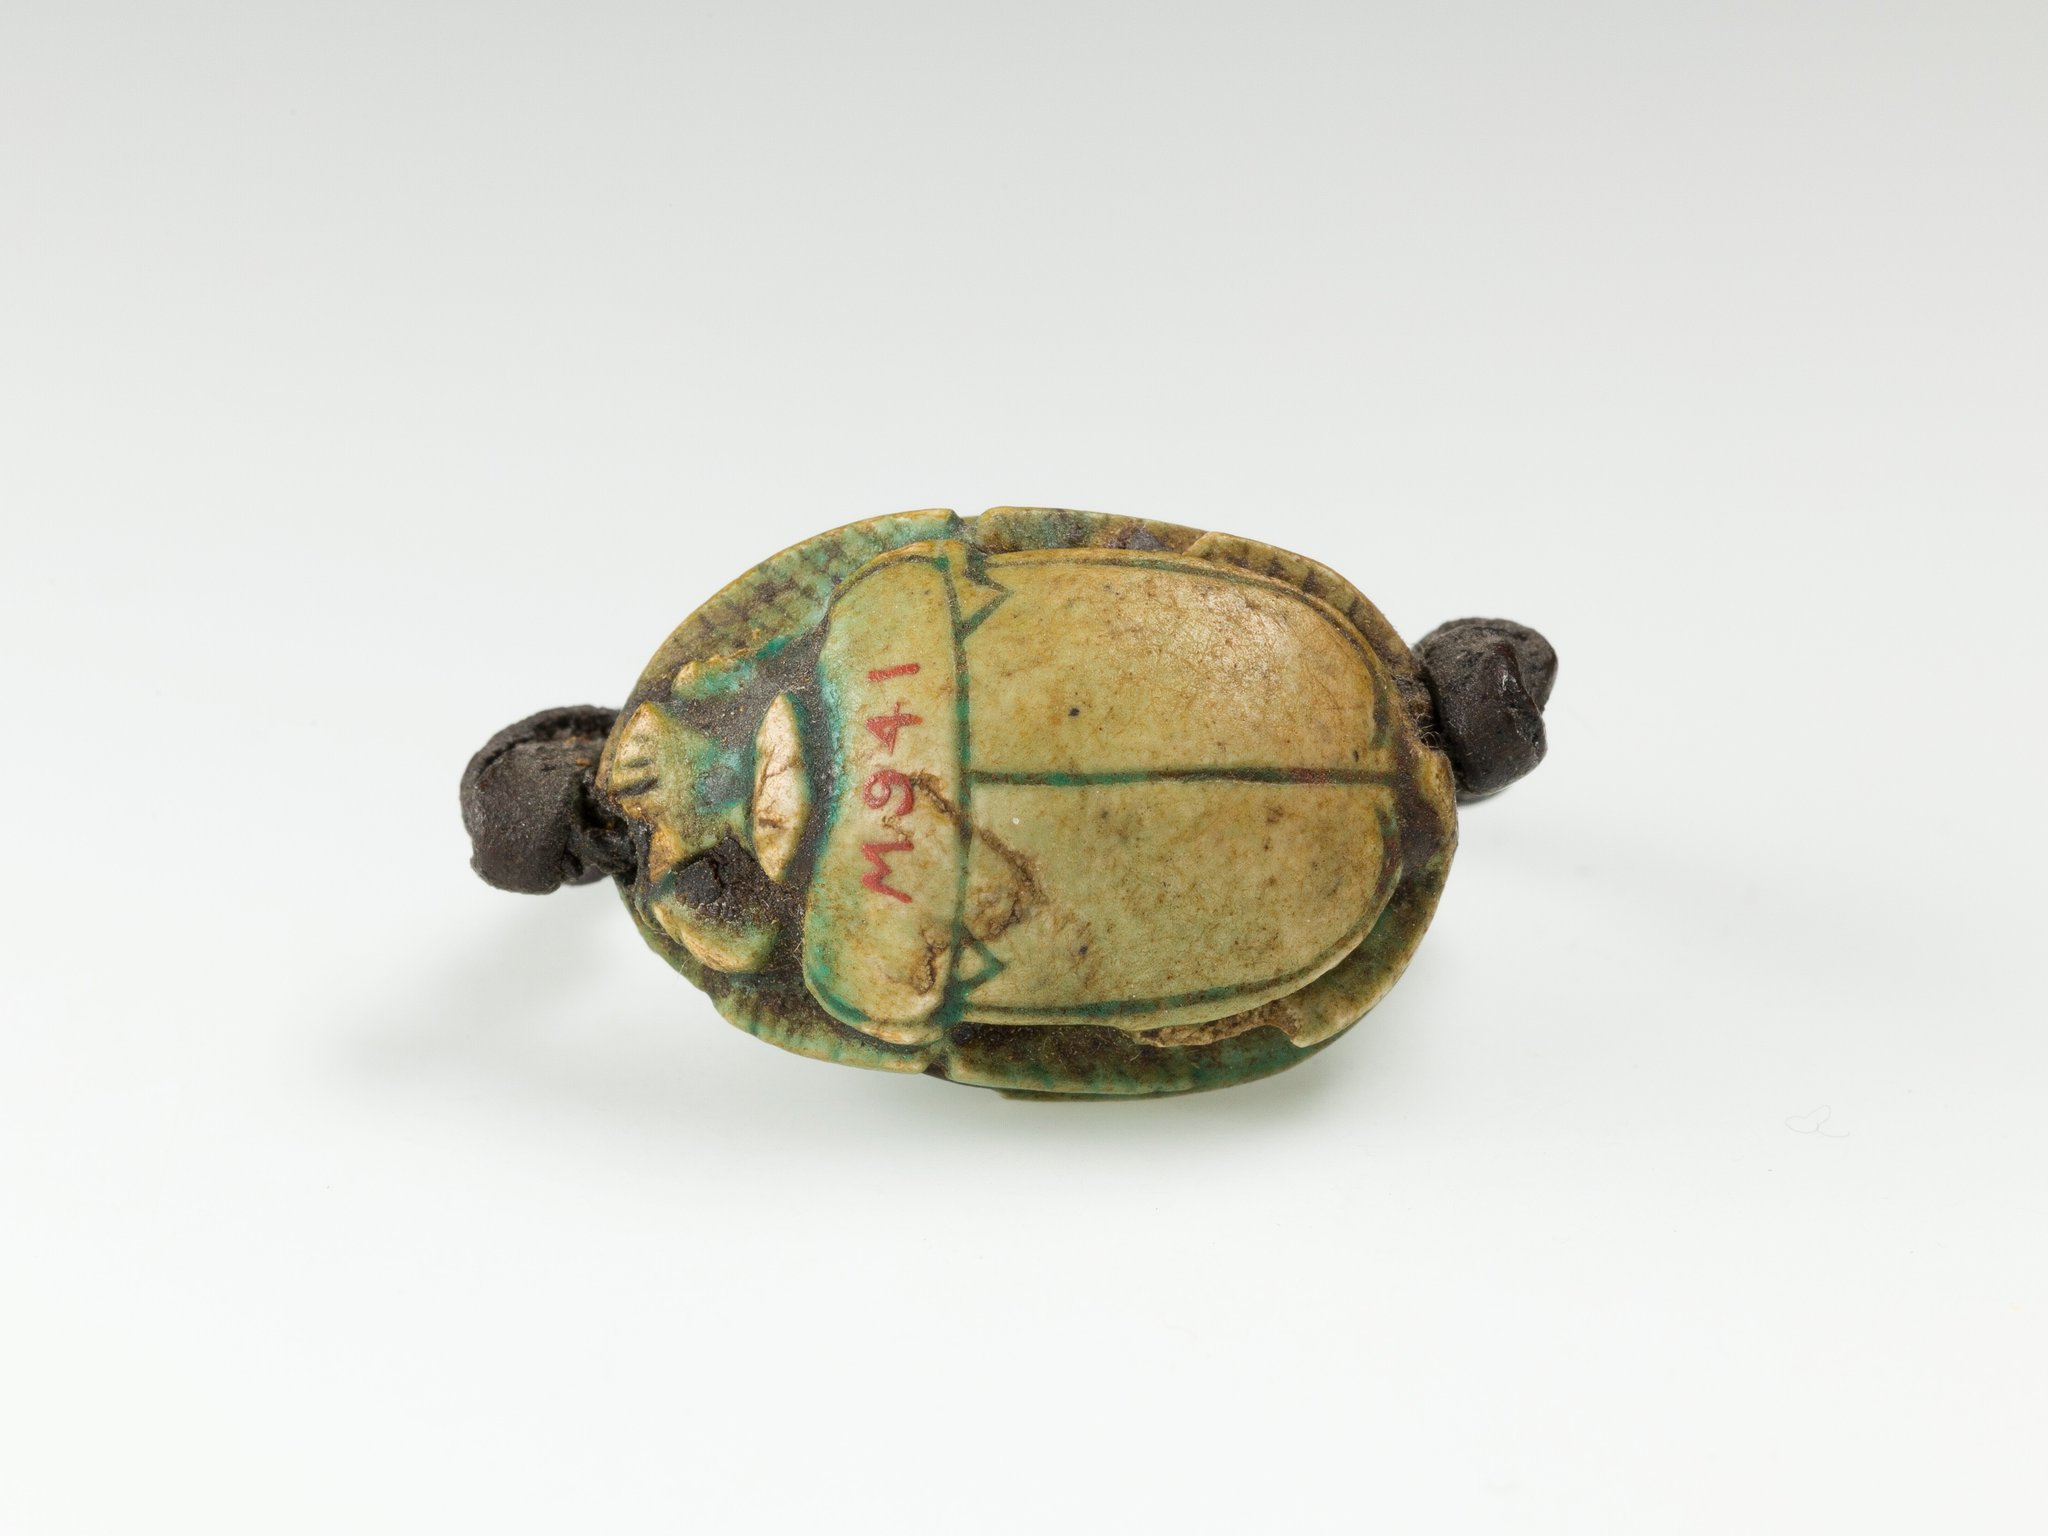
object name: ring, scarab, ramesses ii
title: Scarab Finger Ring of Ramesses II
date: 1295-1070 BCE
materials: bronze, copper alloy, stone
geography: egypt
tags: scarabs